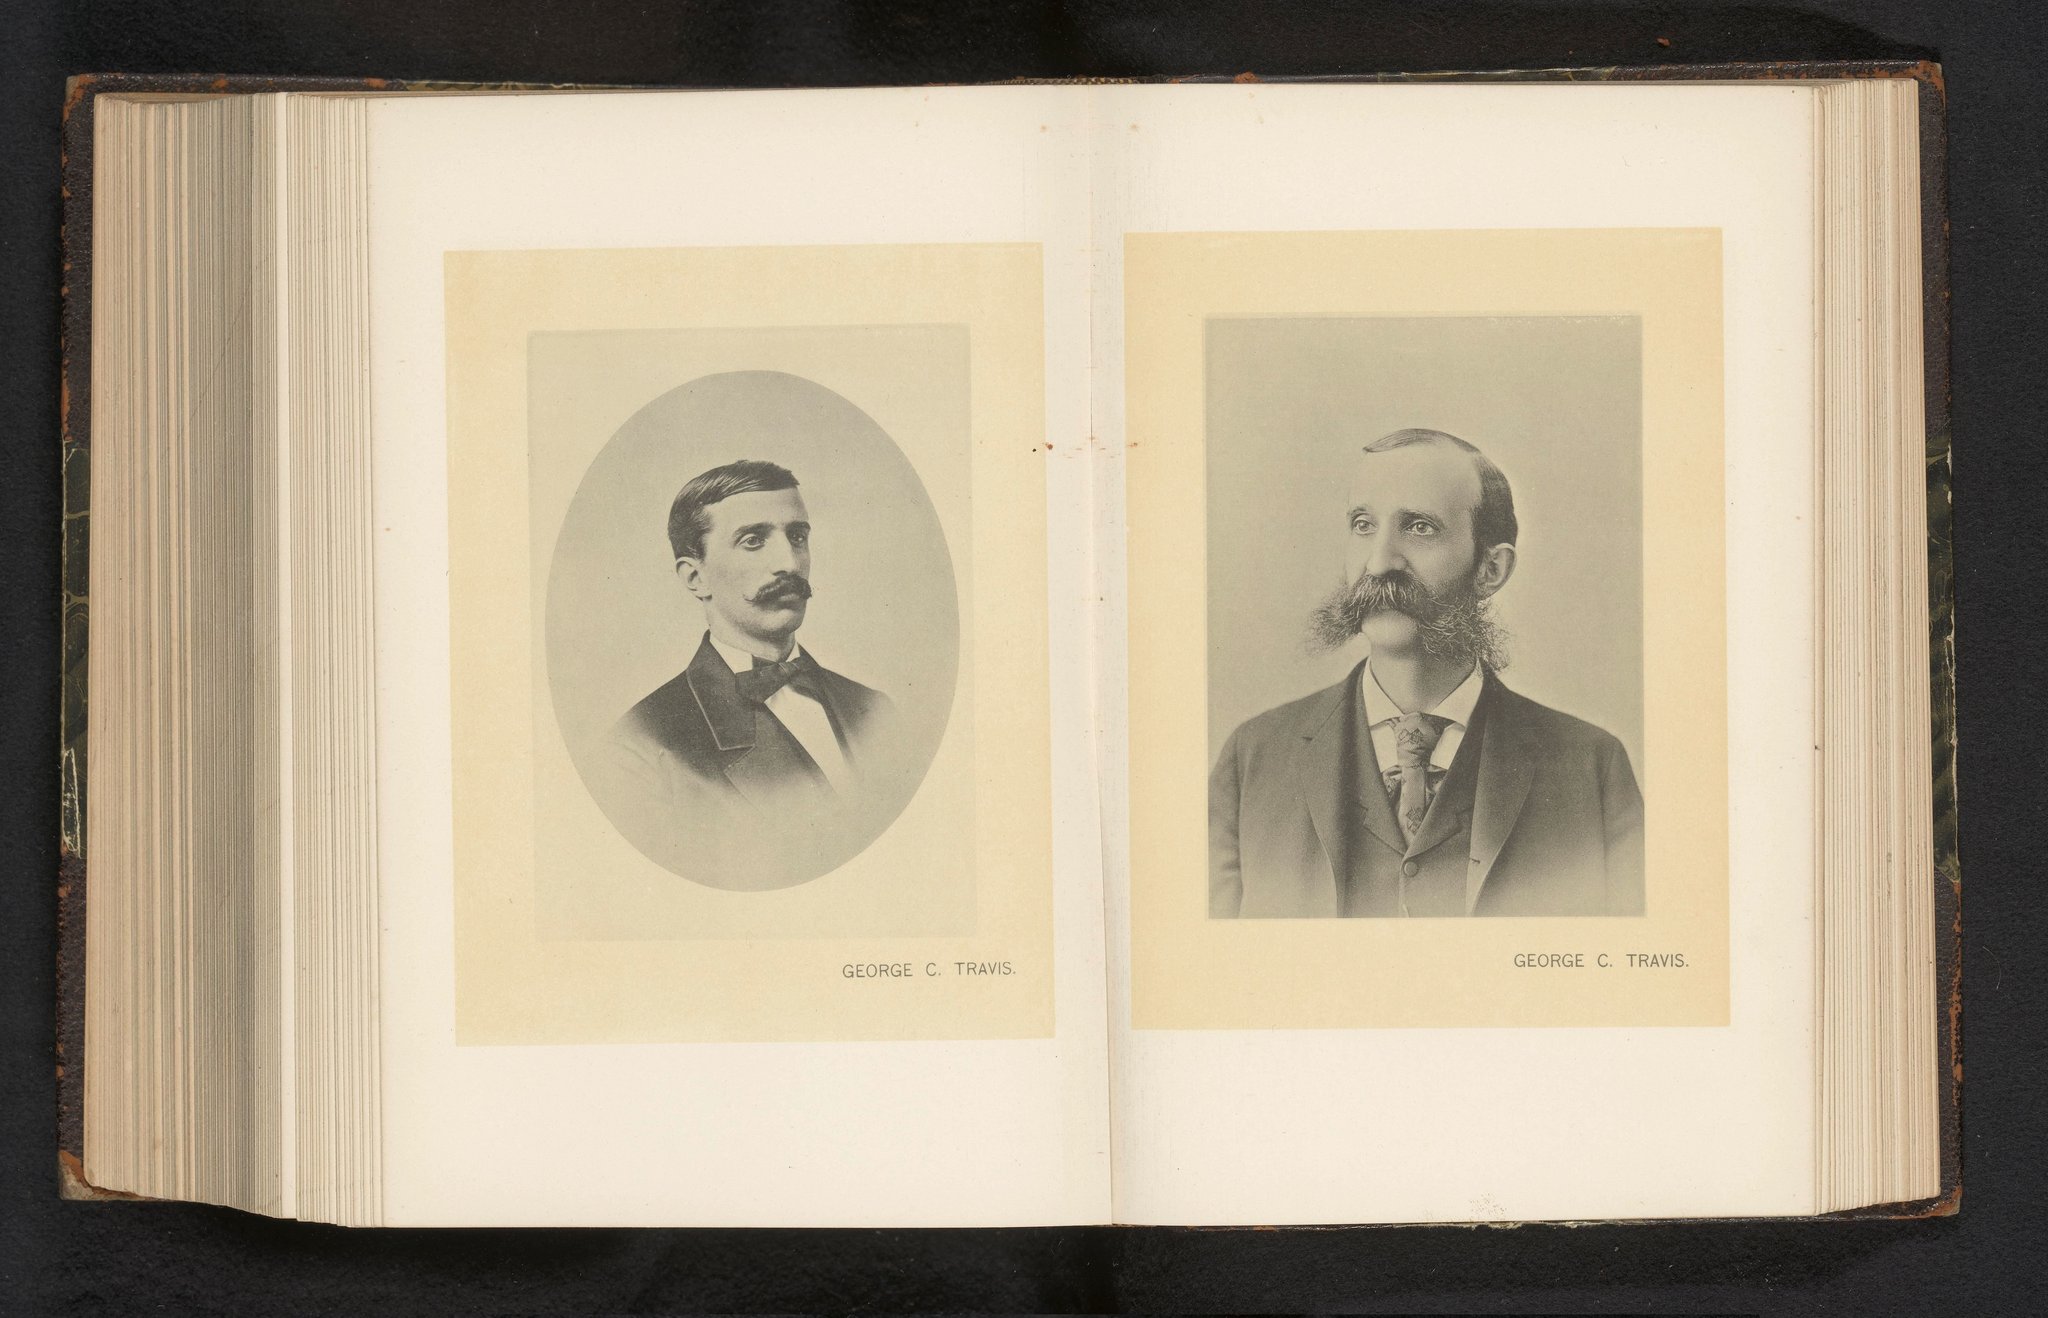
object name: photomechanical print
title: George C. Travis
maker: Anonymous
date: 1869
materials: paper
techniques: photoaquatint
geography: boston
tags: adult man